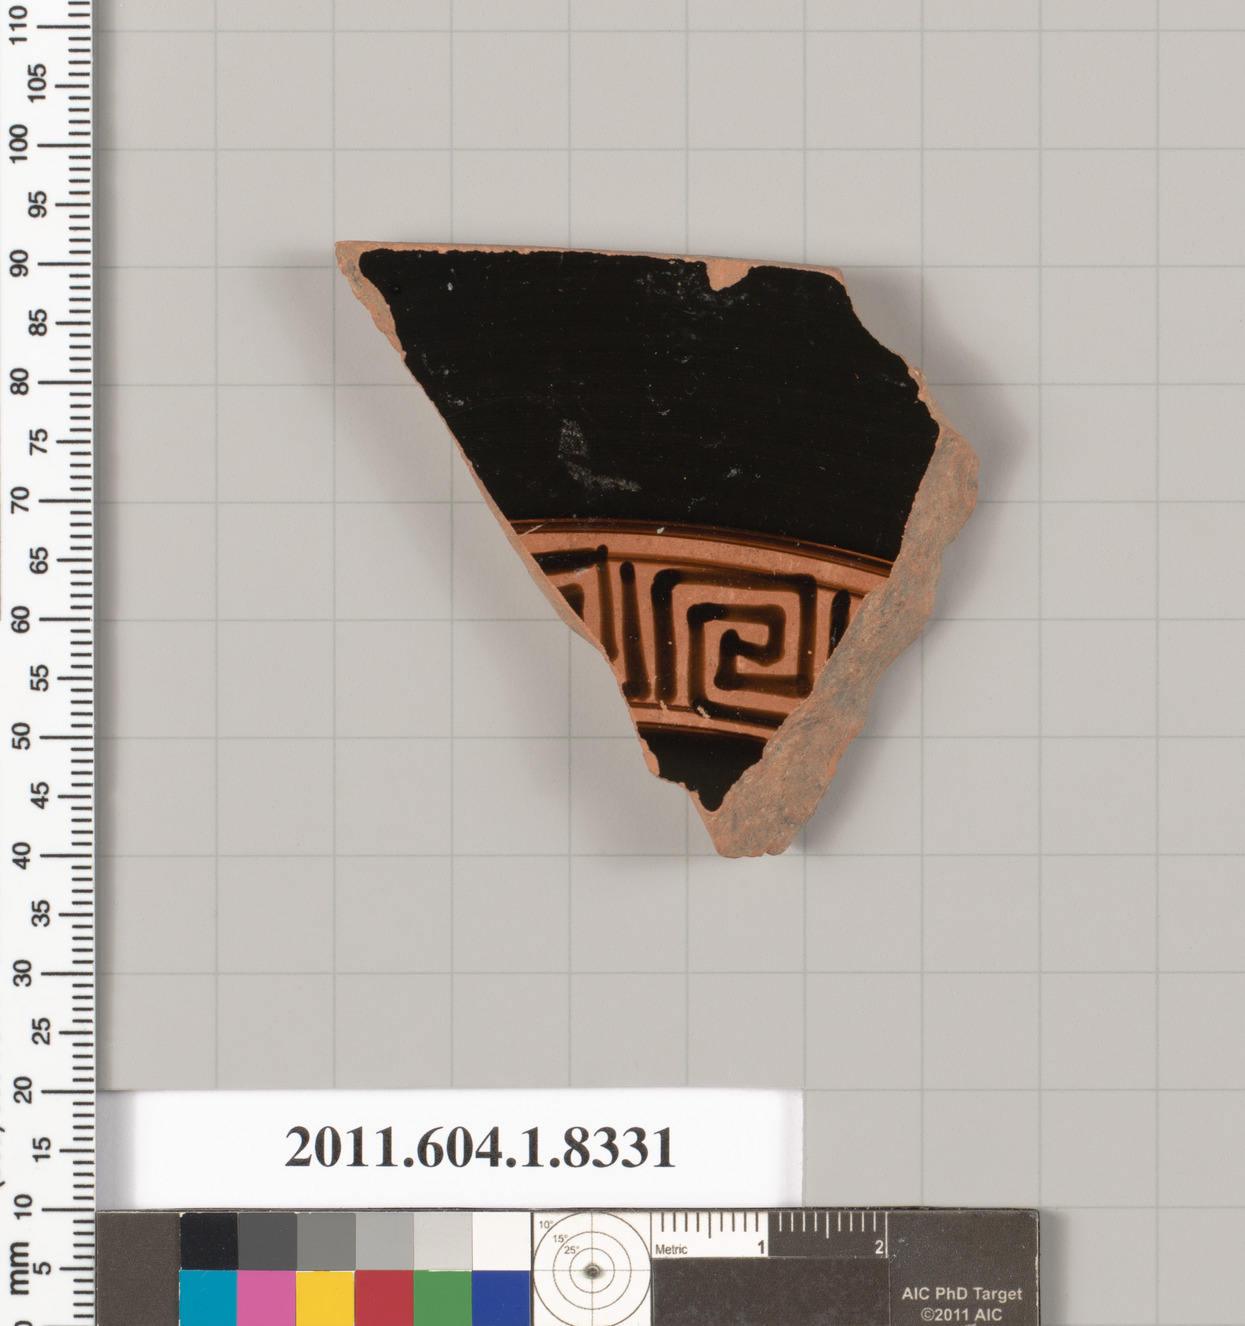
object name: kylix fragment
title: Terracotta fragment of a kylix (drinking cup)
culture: greek, attic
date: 400-376 BCE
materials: terracotta